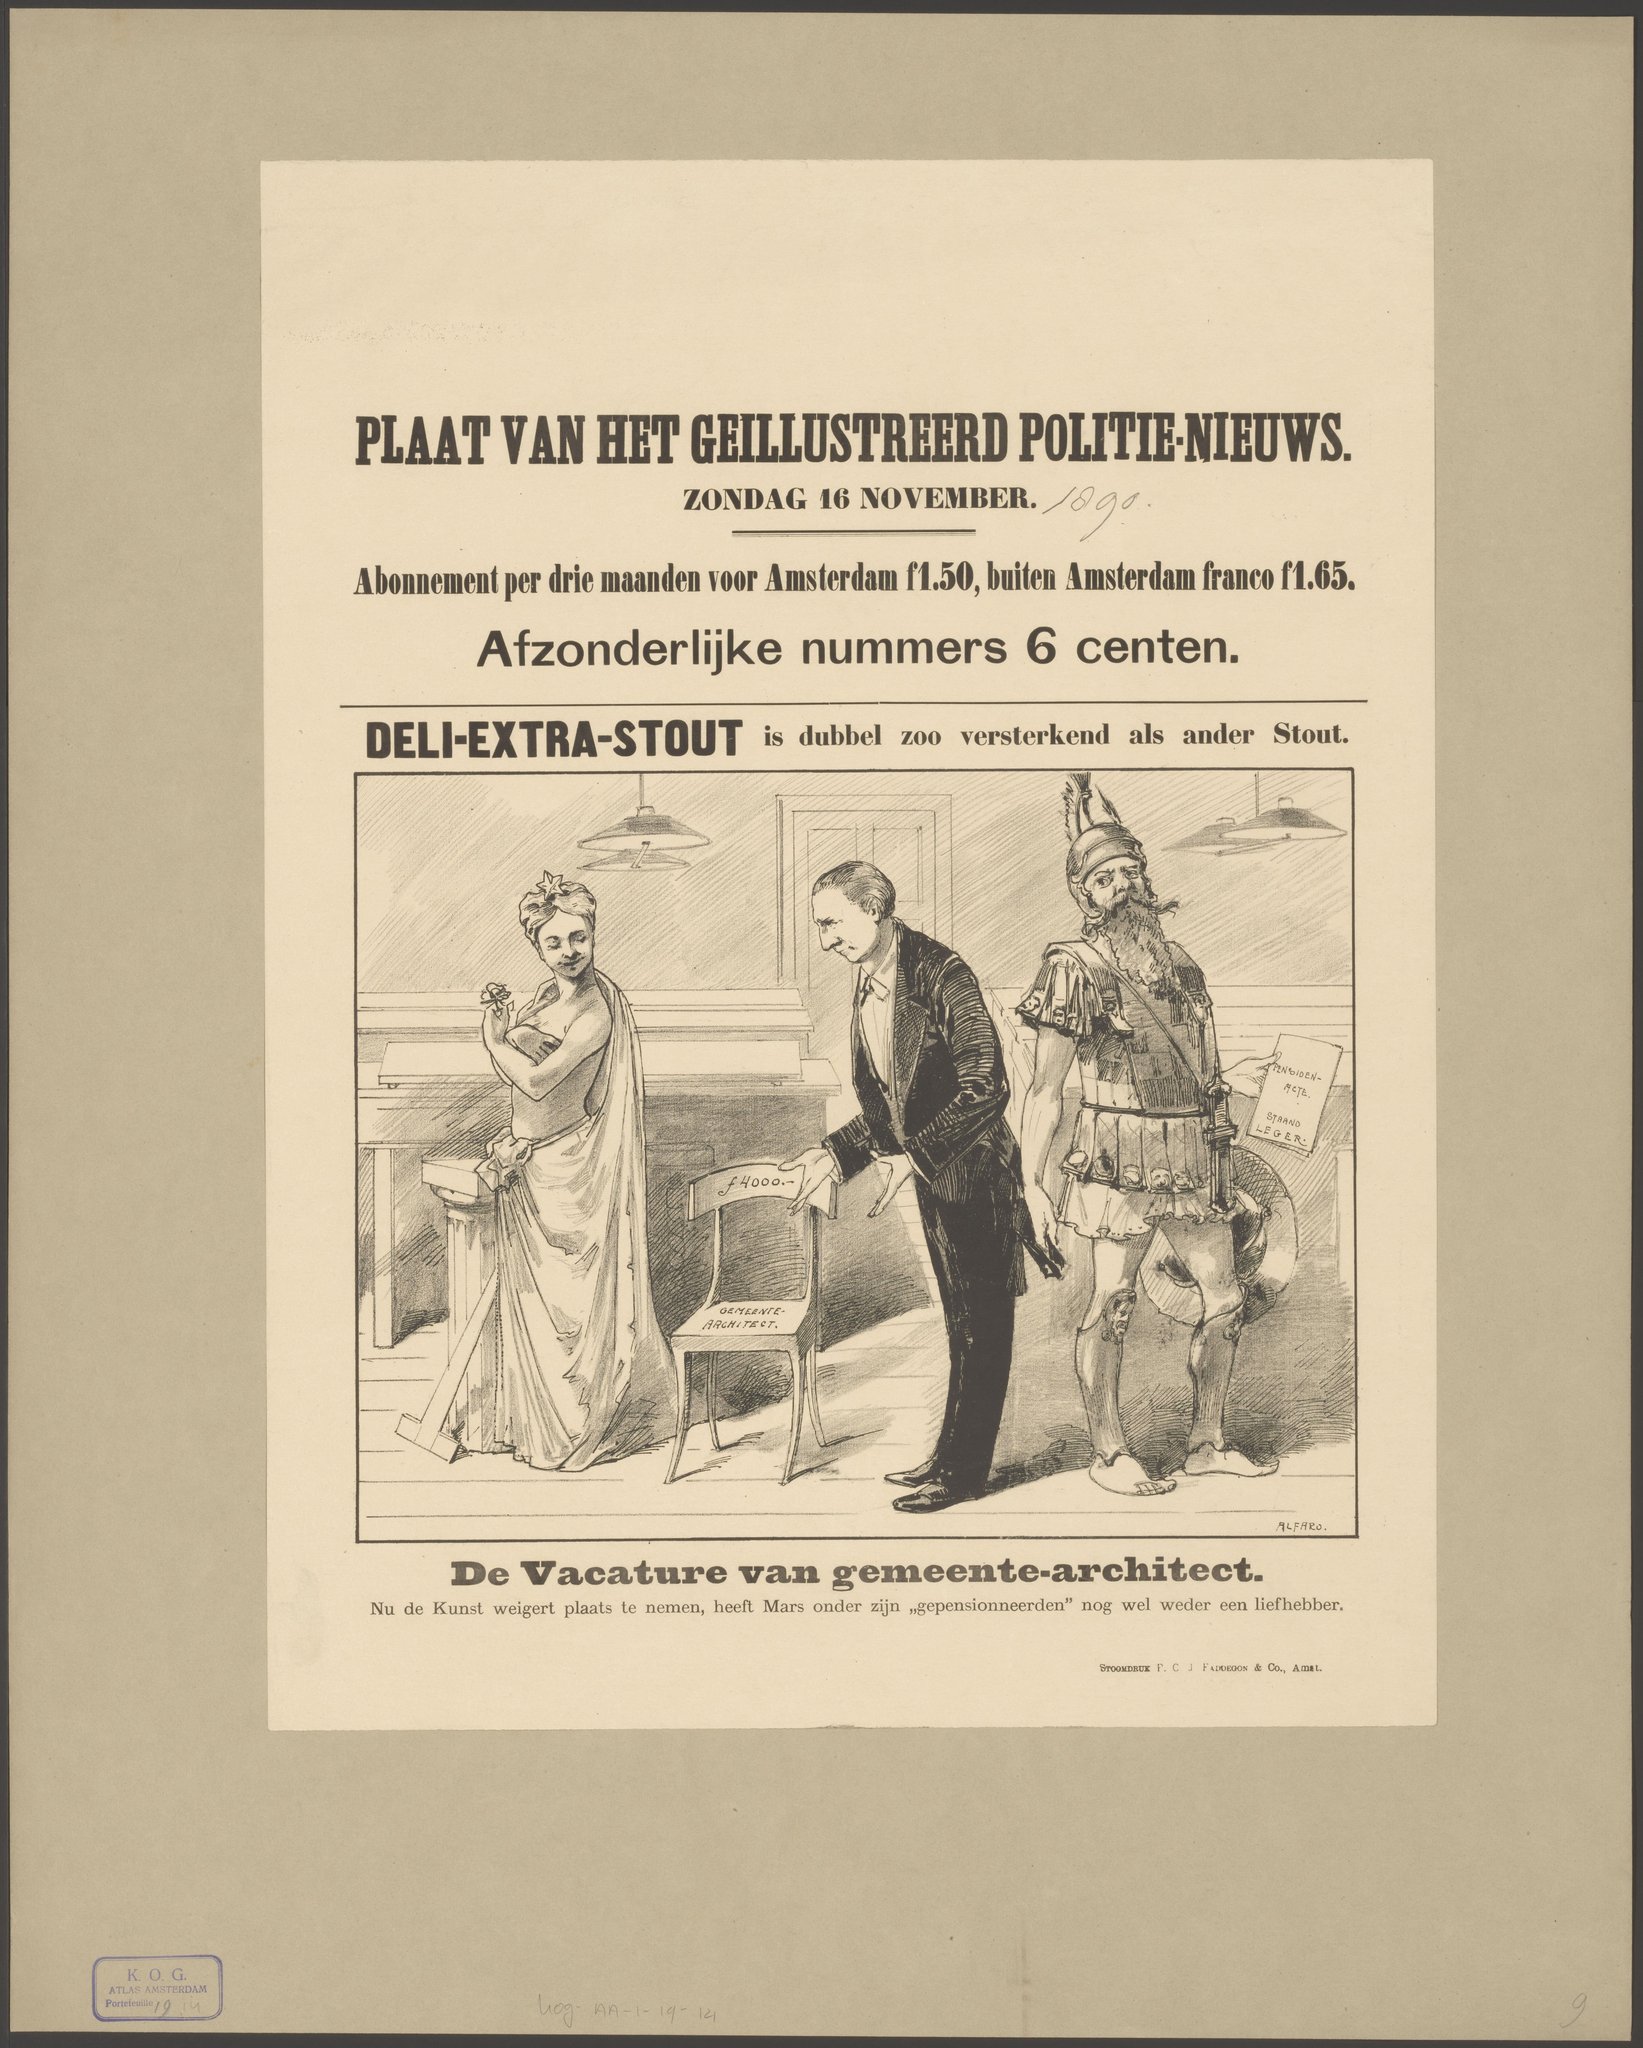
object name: cartoon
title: De Vacature van gemeente-architect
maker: alfaro reijding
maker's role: draughtsman, engineer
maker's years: 1863-1930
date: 1890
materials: paper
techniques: letterpress printing, lithograph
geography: amsterdam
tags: city council, (story of) mars (ares), symbolic representations, allegories and emblems ~ art; 'arte' (ripa), political caricatures and satires, amsterdam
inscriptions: collector's mark: ‘19,14’ Lugt 1641b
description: Onderwerpsrubriek binnen de Atlas Amsterdam: Herinneringen aan regeringsleden en hunne huisgezinnen [na 1800].